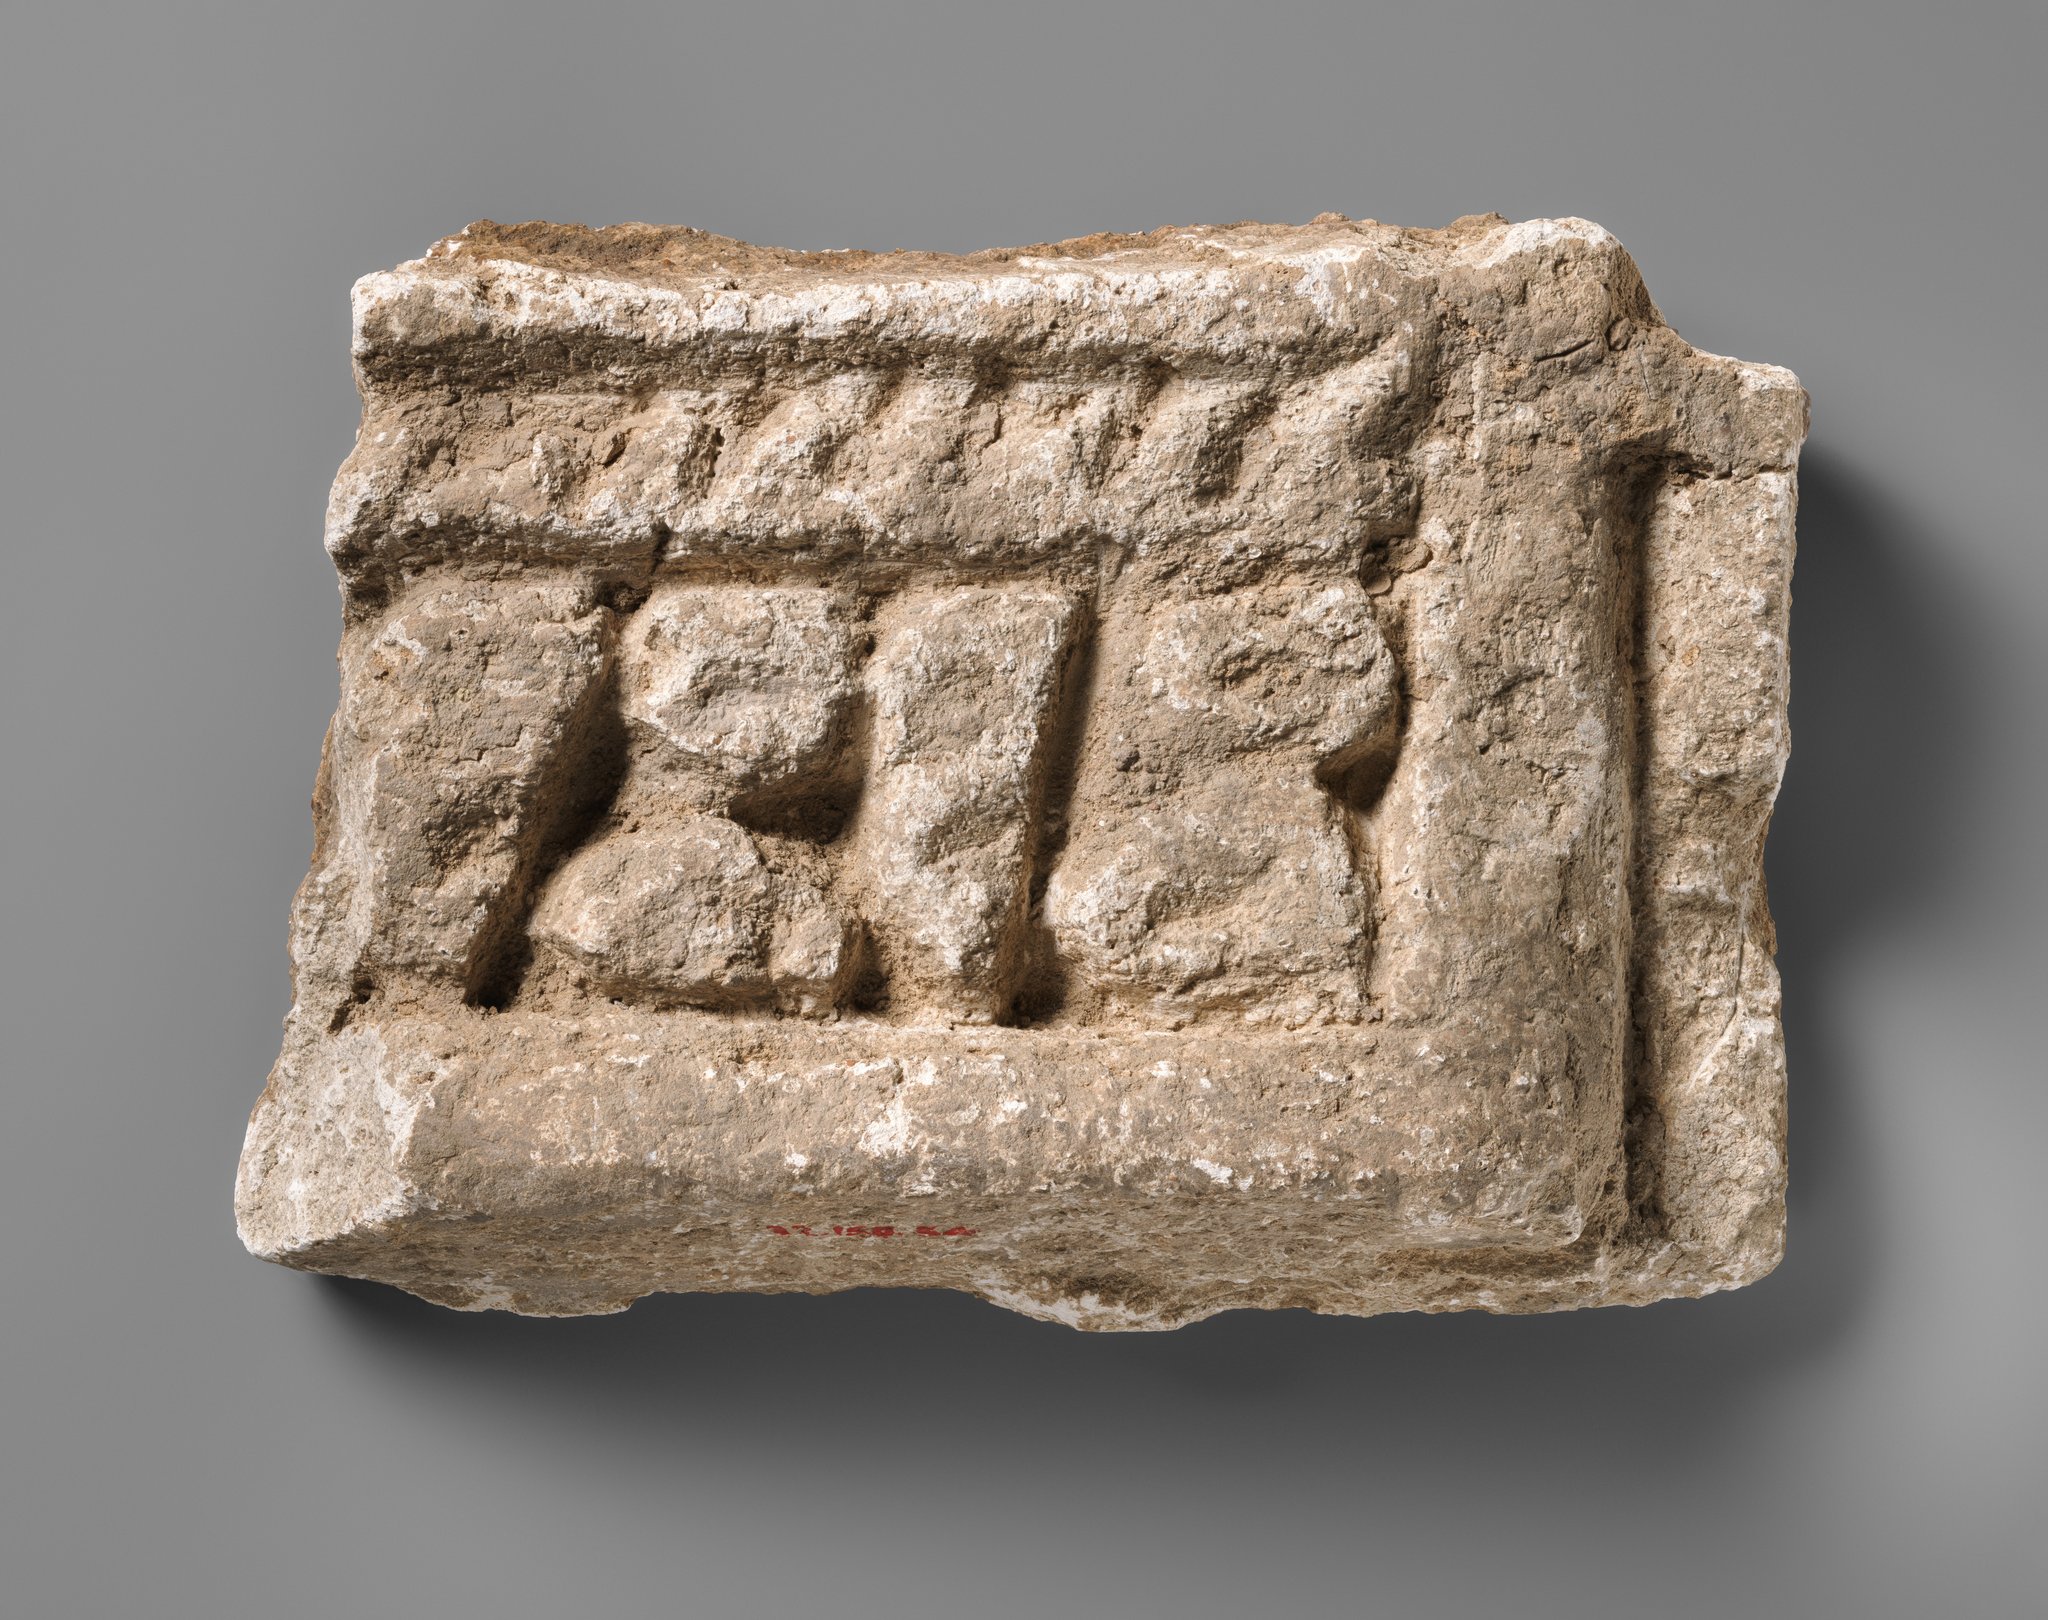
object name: relief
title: Relief fragment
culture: sasanian or islamic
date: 501-800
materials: plaster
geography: mesopotamia